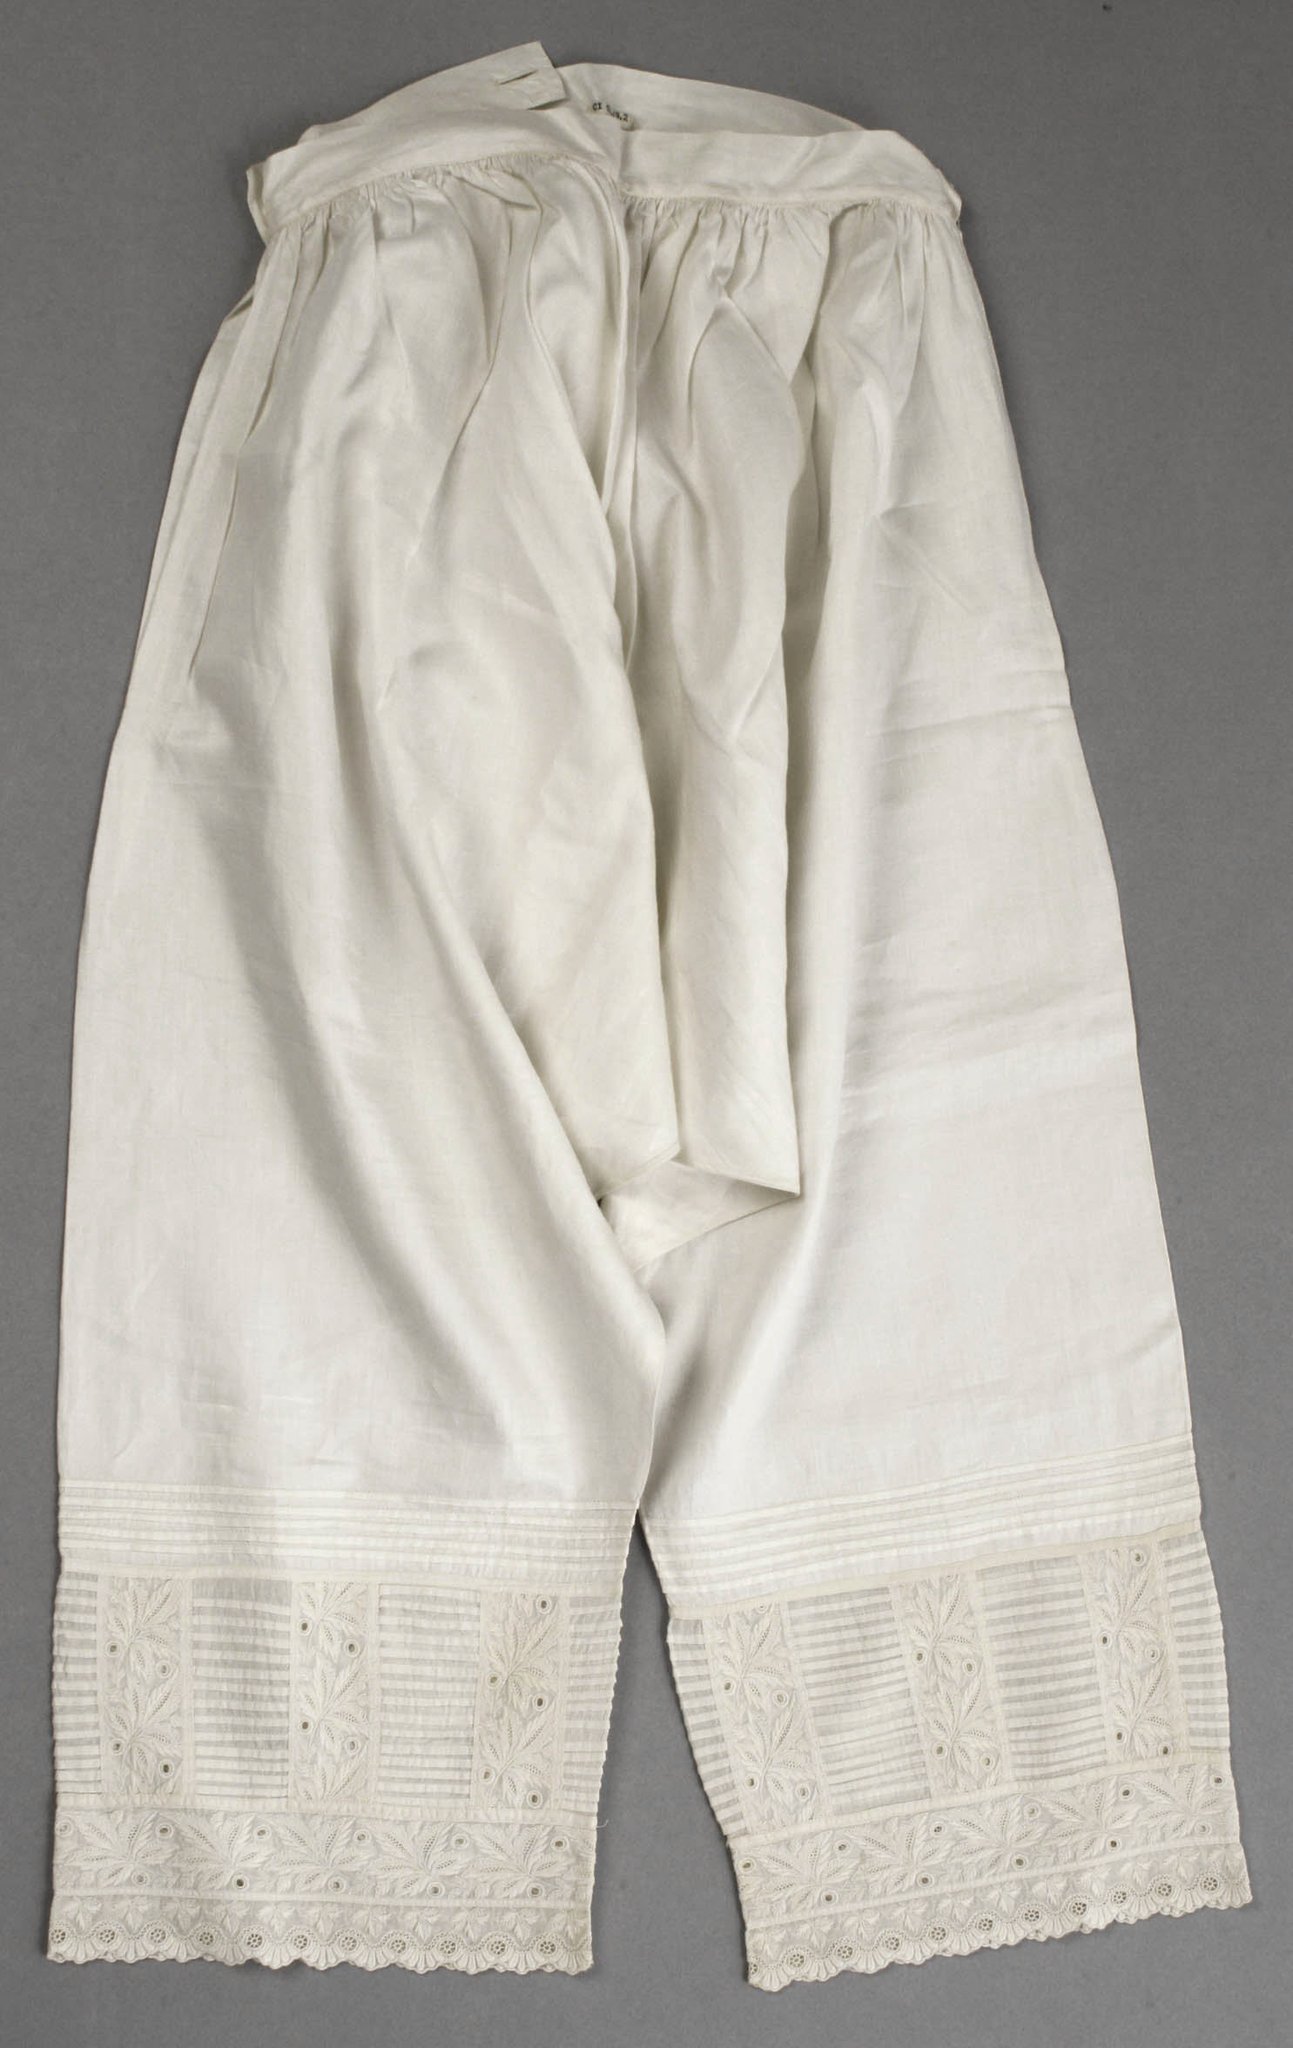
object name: drawer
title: Drawers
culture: american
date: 1874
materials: cotton, linen